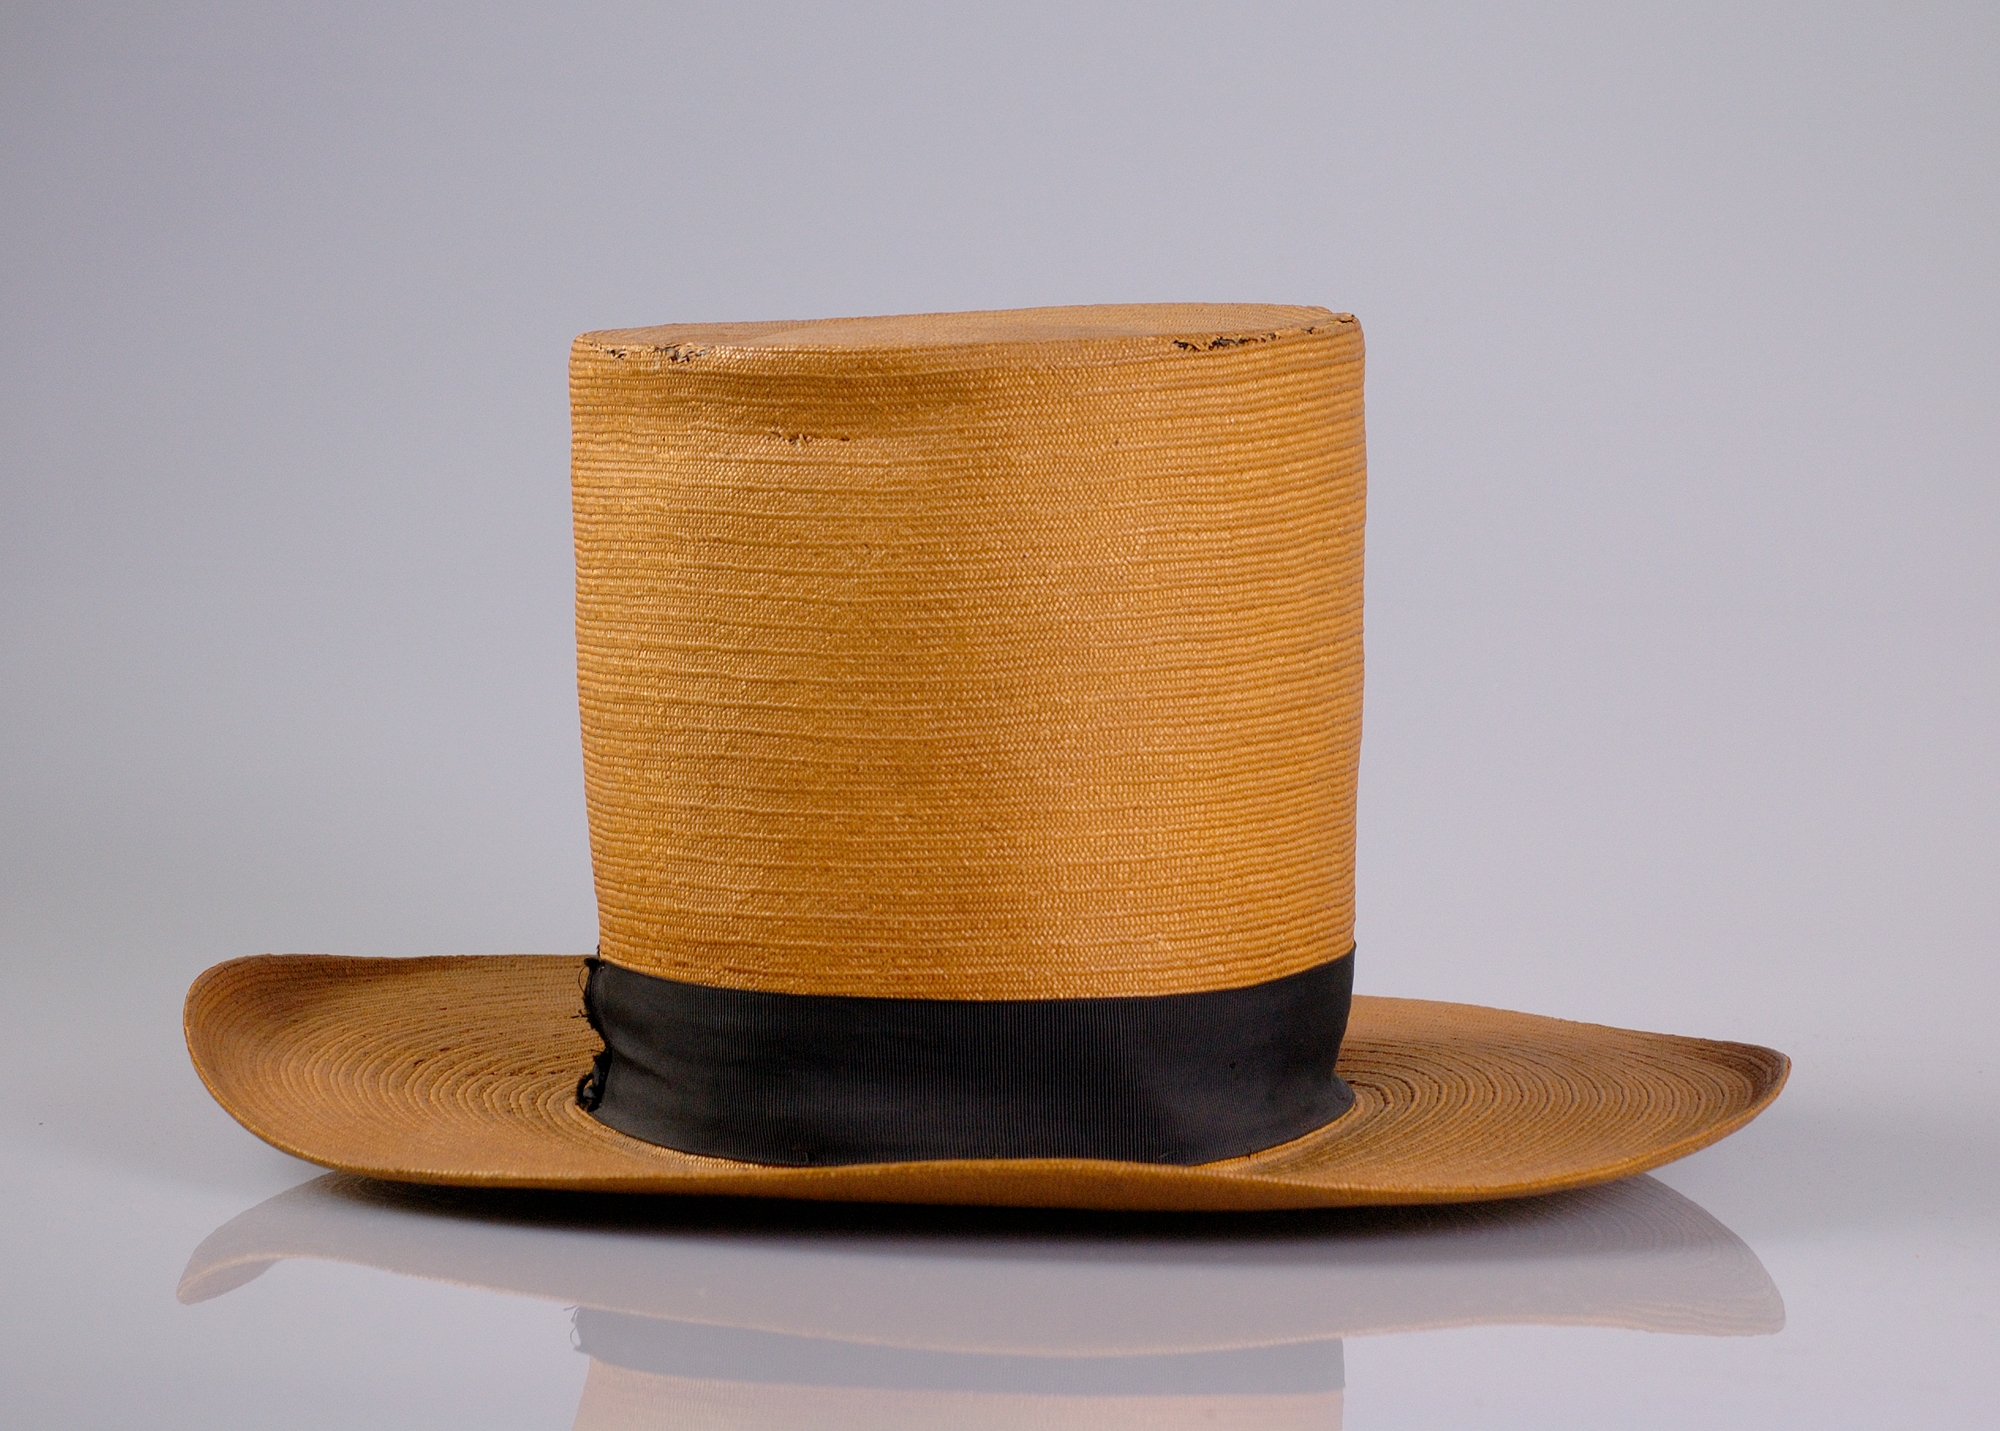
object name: hat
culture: american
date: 1840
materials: silk, fiber